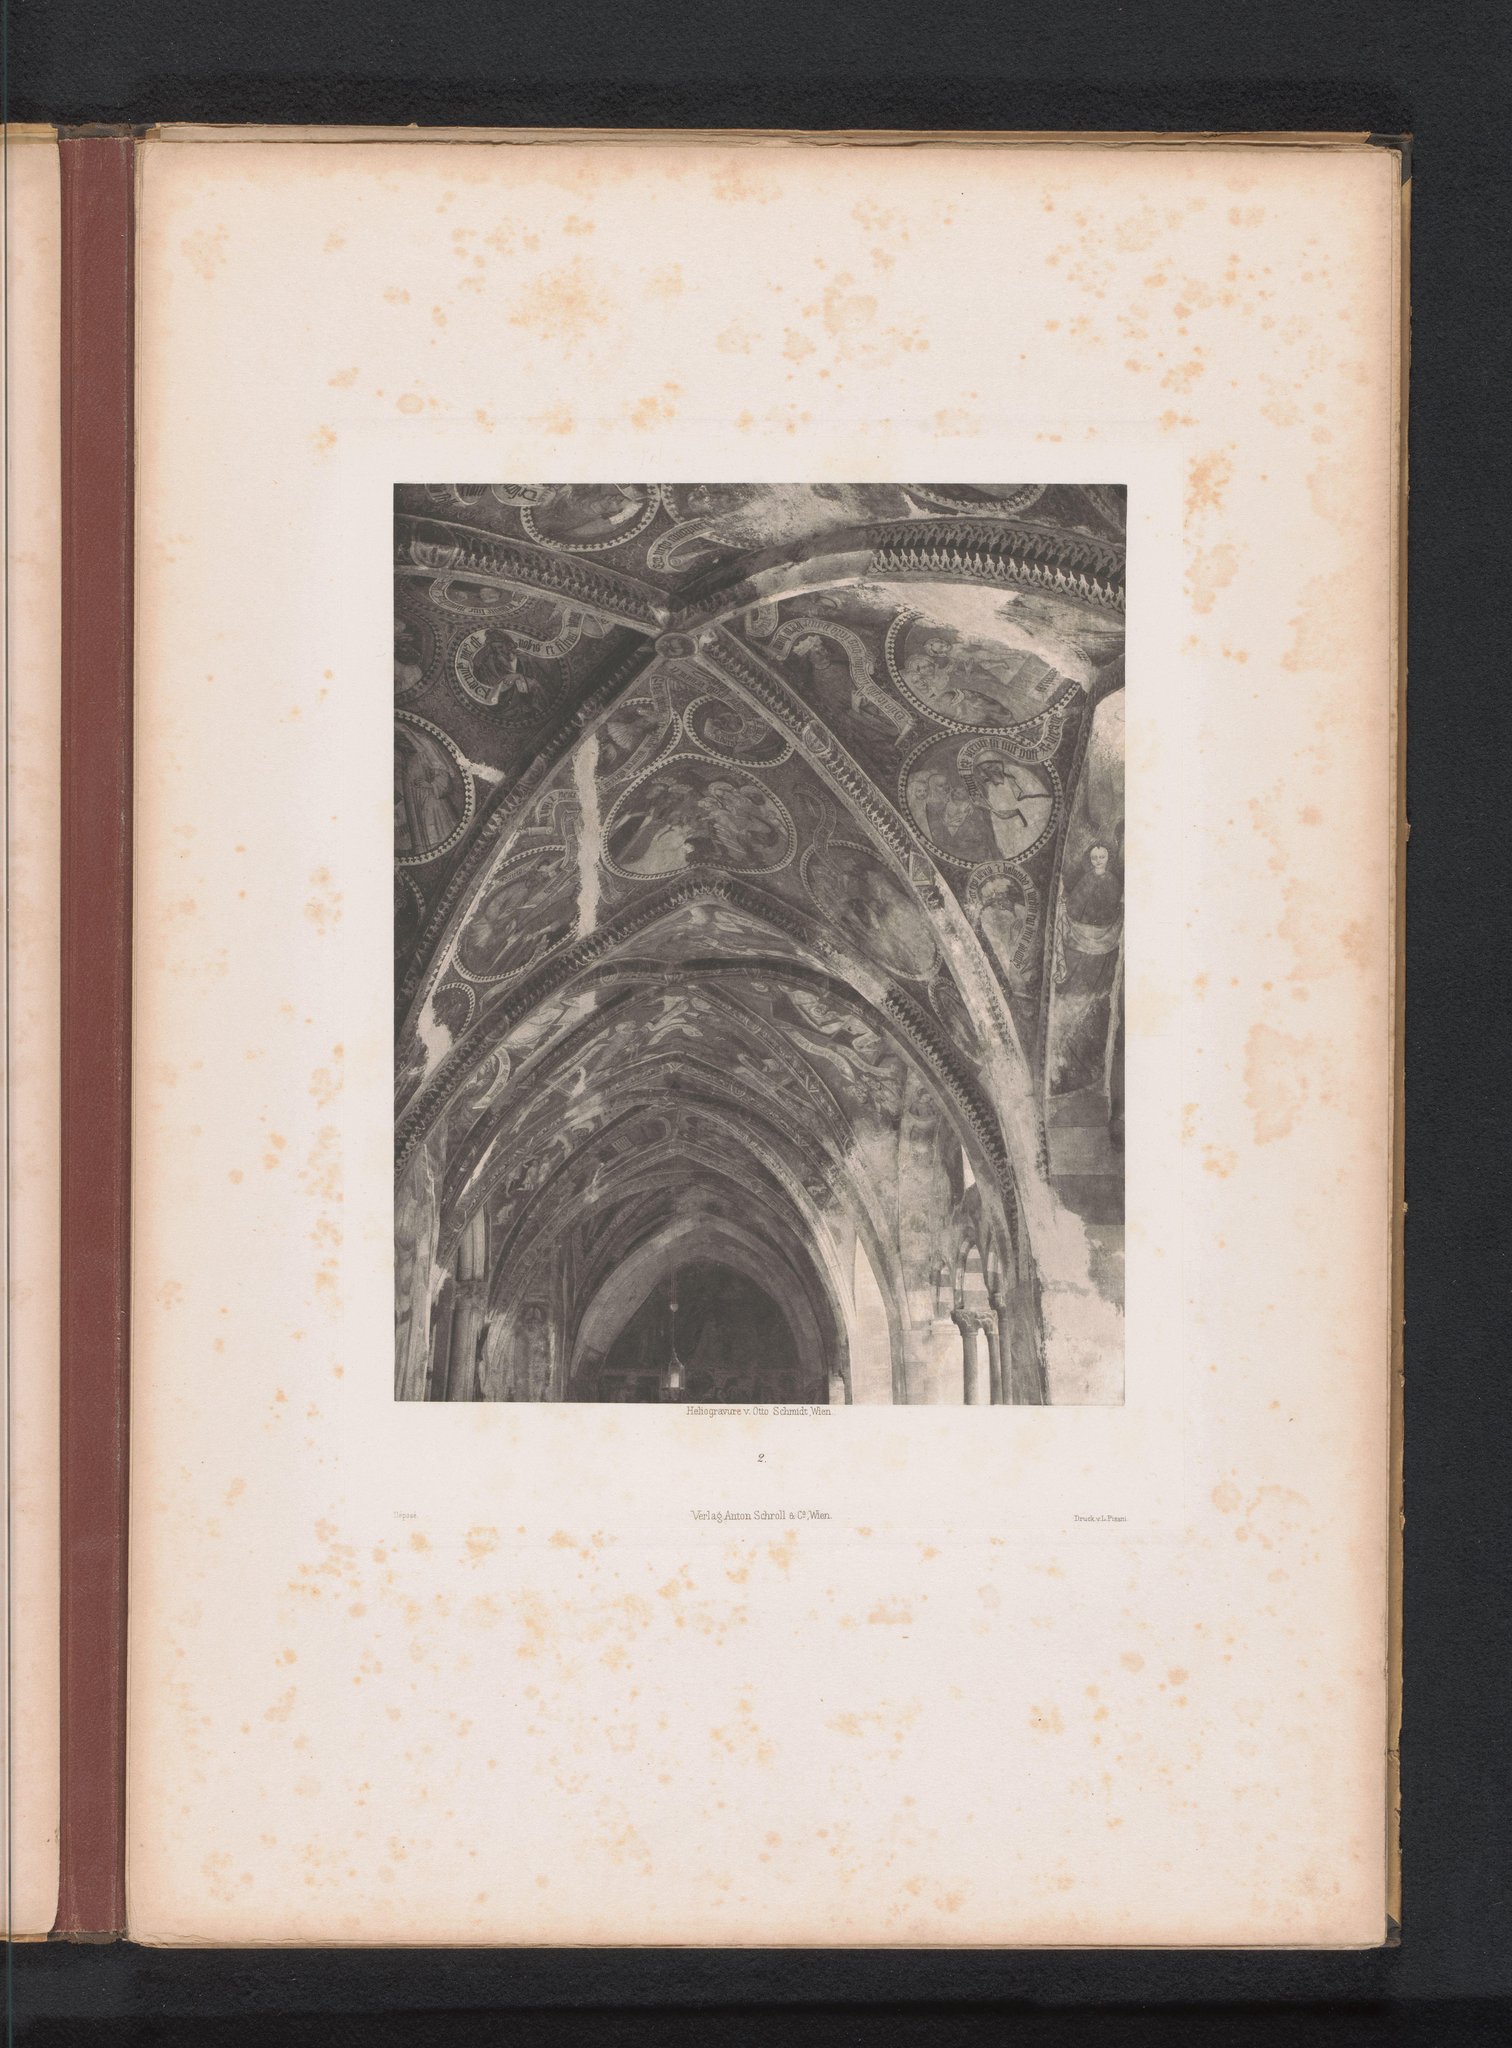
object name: photomechanical print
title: Fresco's in de kruisgang van de Dom van Bressanone, Italië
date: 1888-1893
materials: paper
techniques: photoaquatint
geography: vienna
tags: interior of church, picture, painting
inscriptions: inscription: ‘Déposé.’, number: ‘2.’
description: Deze prent maakt deel uit van een omslag met twintig prenten, twee tekstbladen en een titelpagina.